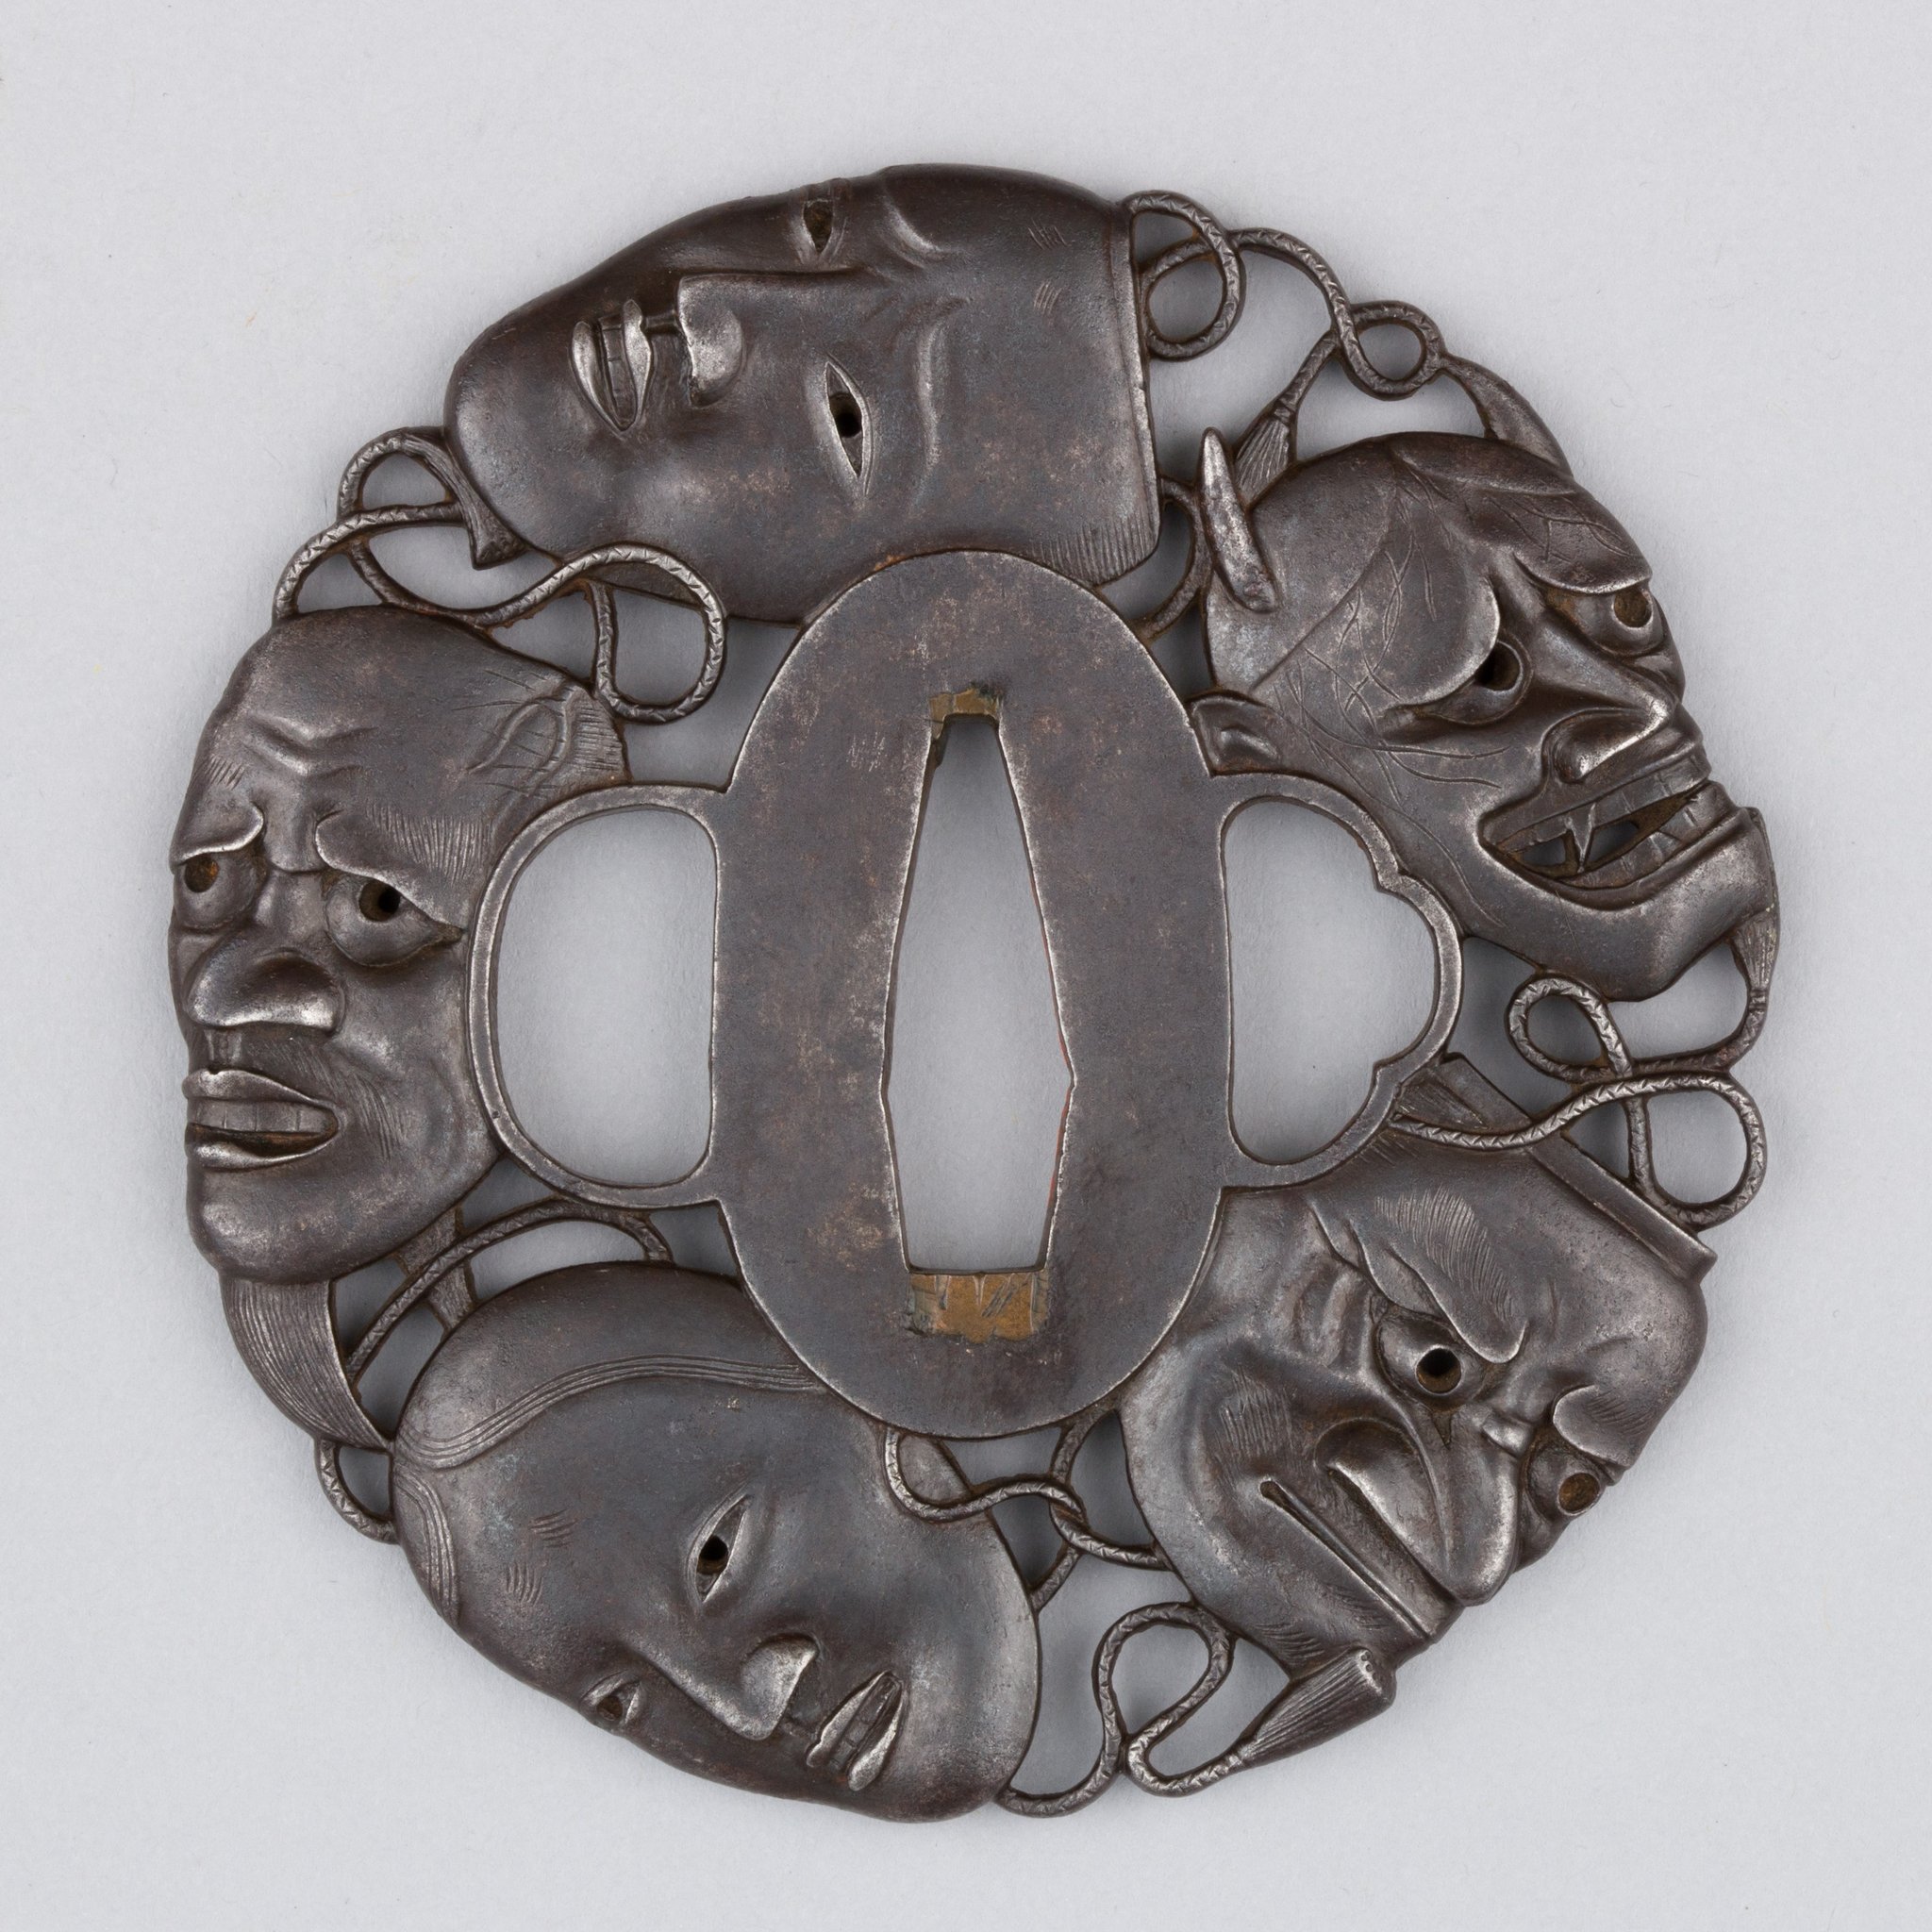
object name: sword guard tsuba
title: Sword Guard (Tsuba)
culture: japanese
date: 1701-1800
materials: copper, iron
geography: japan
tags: masks